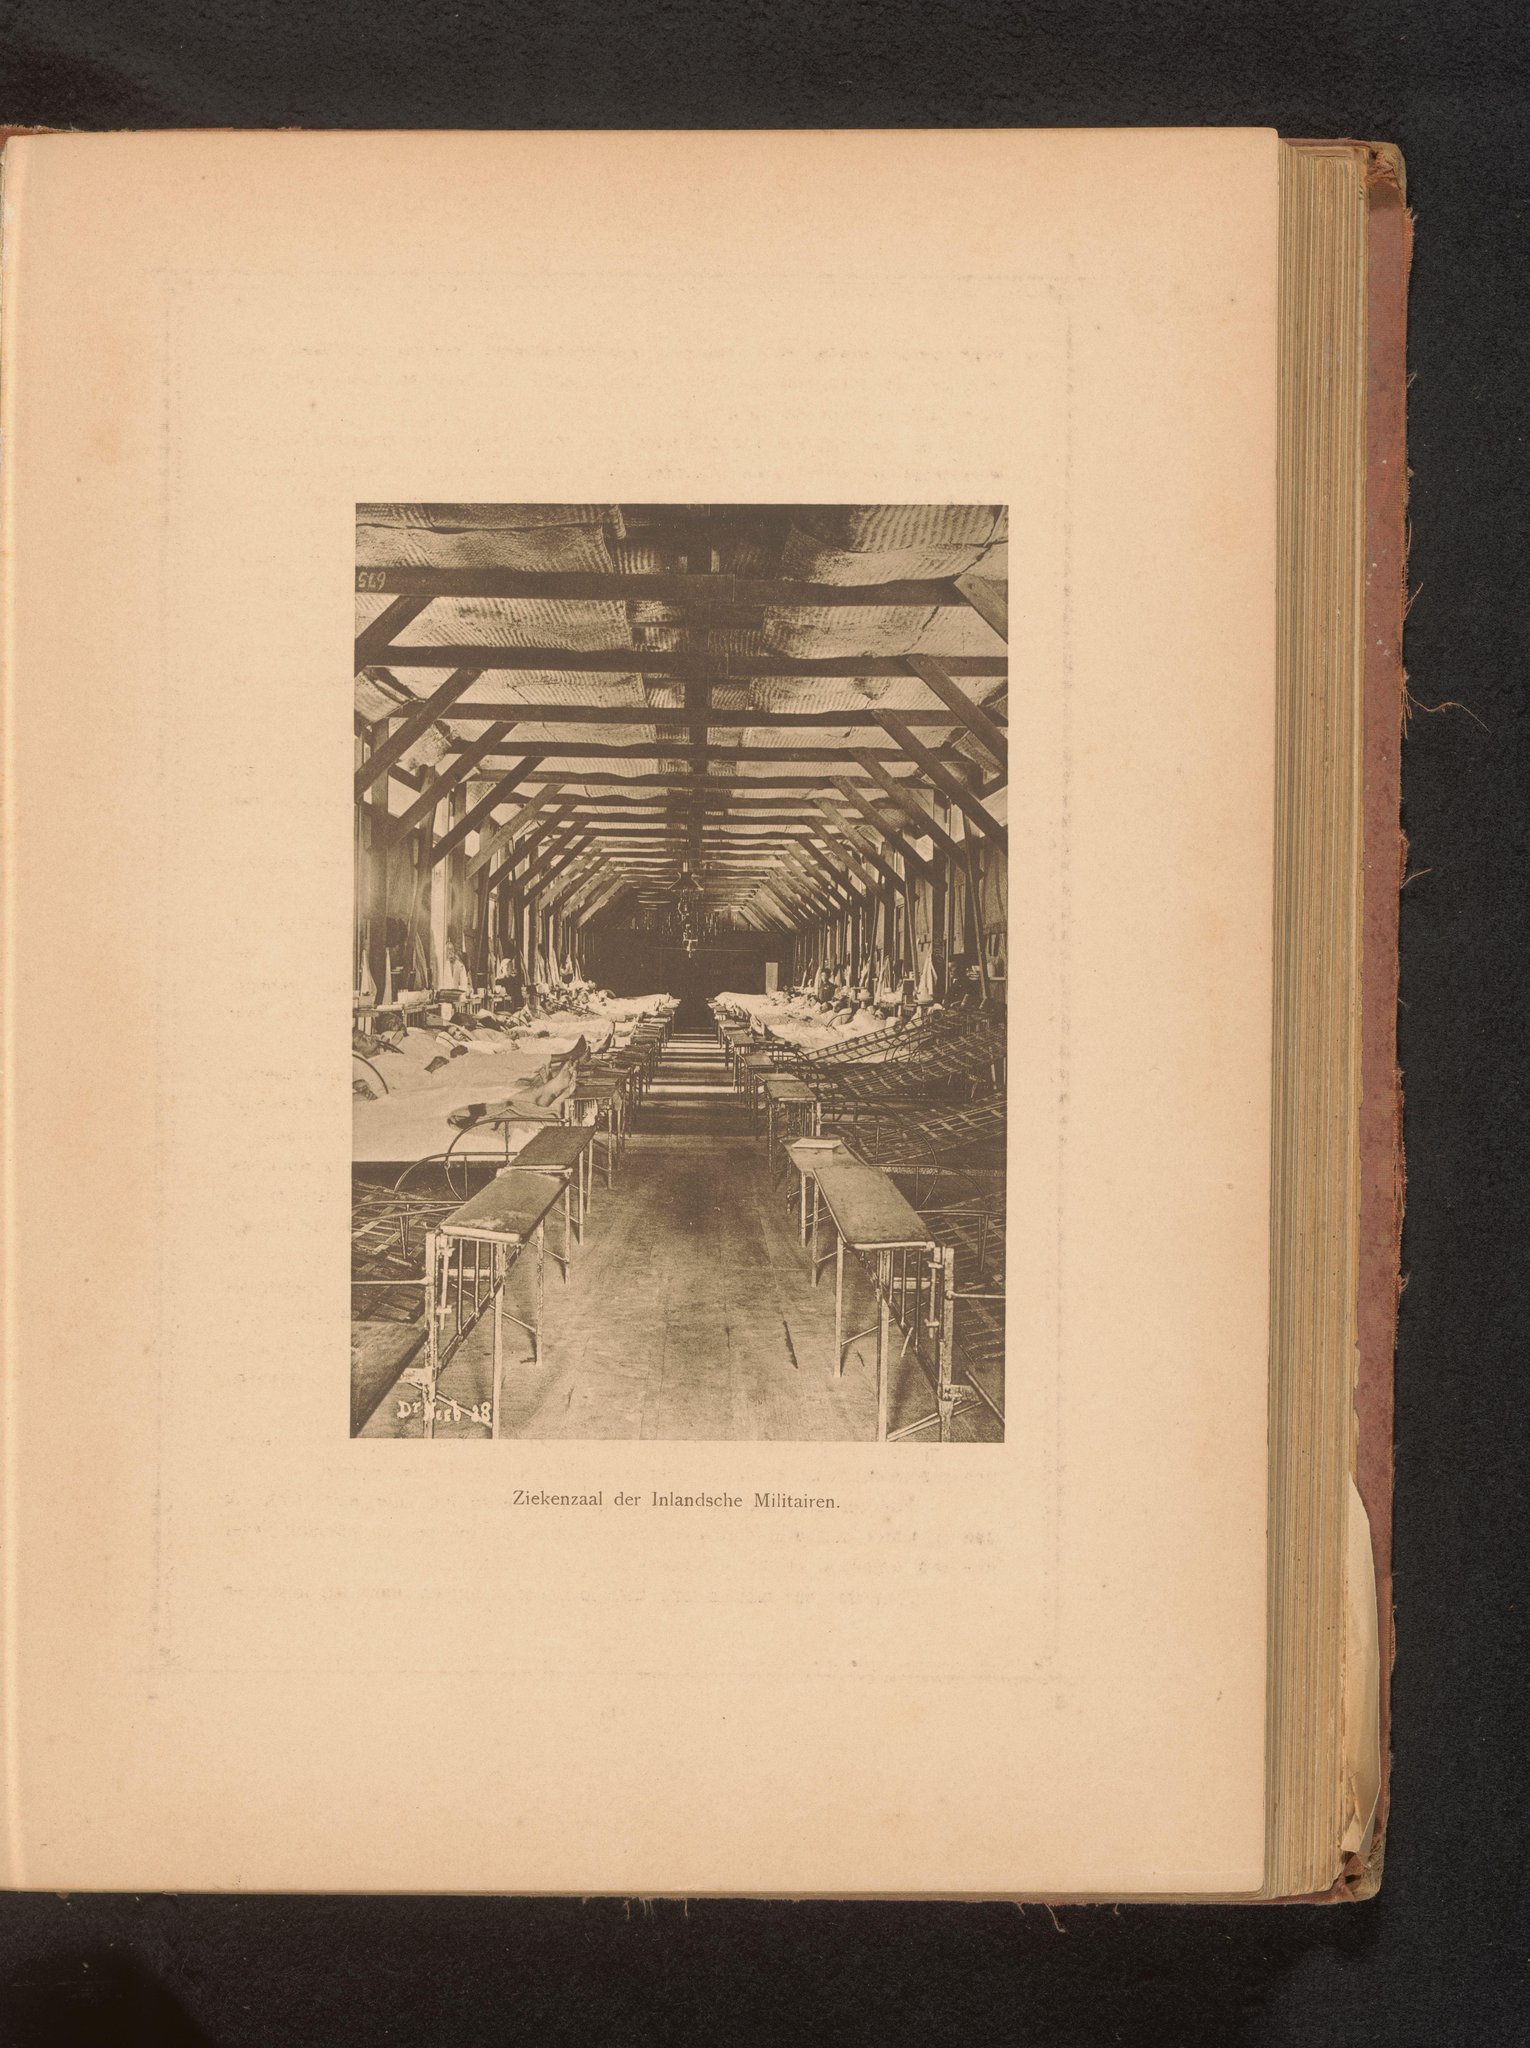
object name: page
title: Ziekenzaal der Inlandsche Militairen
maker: christiaan johan neeb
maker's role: arts, fotograaf, officier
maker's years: 1860-1925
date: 1892-1897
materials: paper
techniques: photograph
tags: sick-bed, ward; room (in hospital)